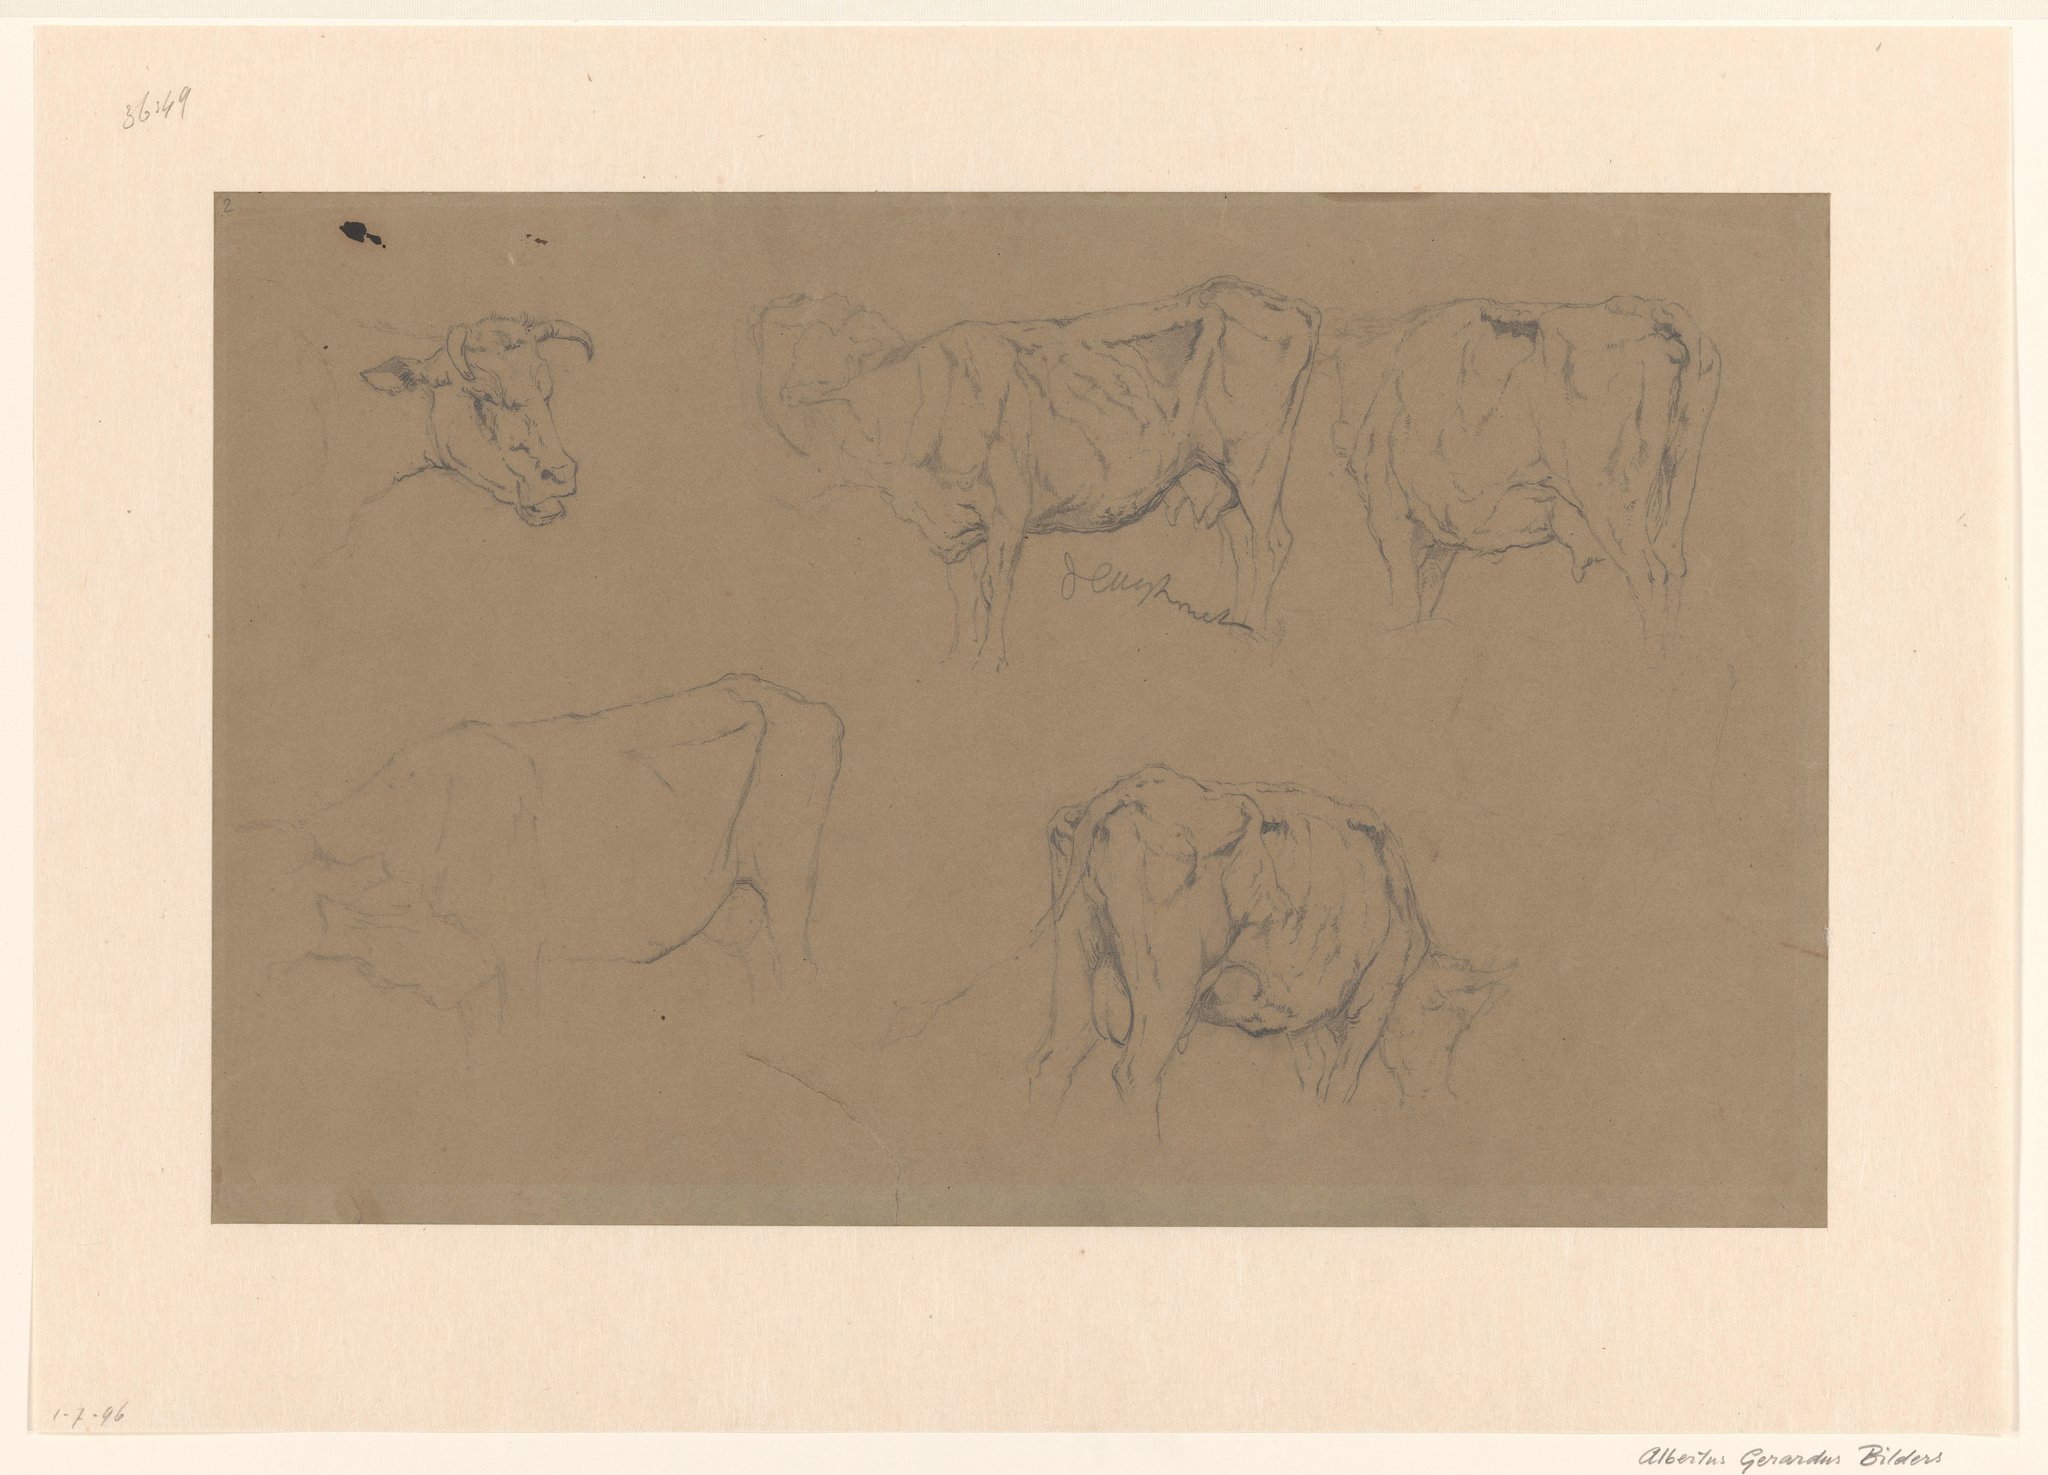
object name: drawing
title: Schetsblad met studies van koeien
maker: gerard bilders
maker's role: draughtsman, print maker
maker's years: 1838-1865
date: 1848-1865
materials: paper, pencil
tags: cow